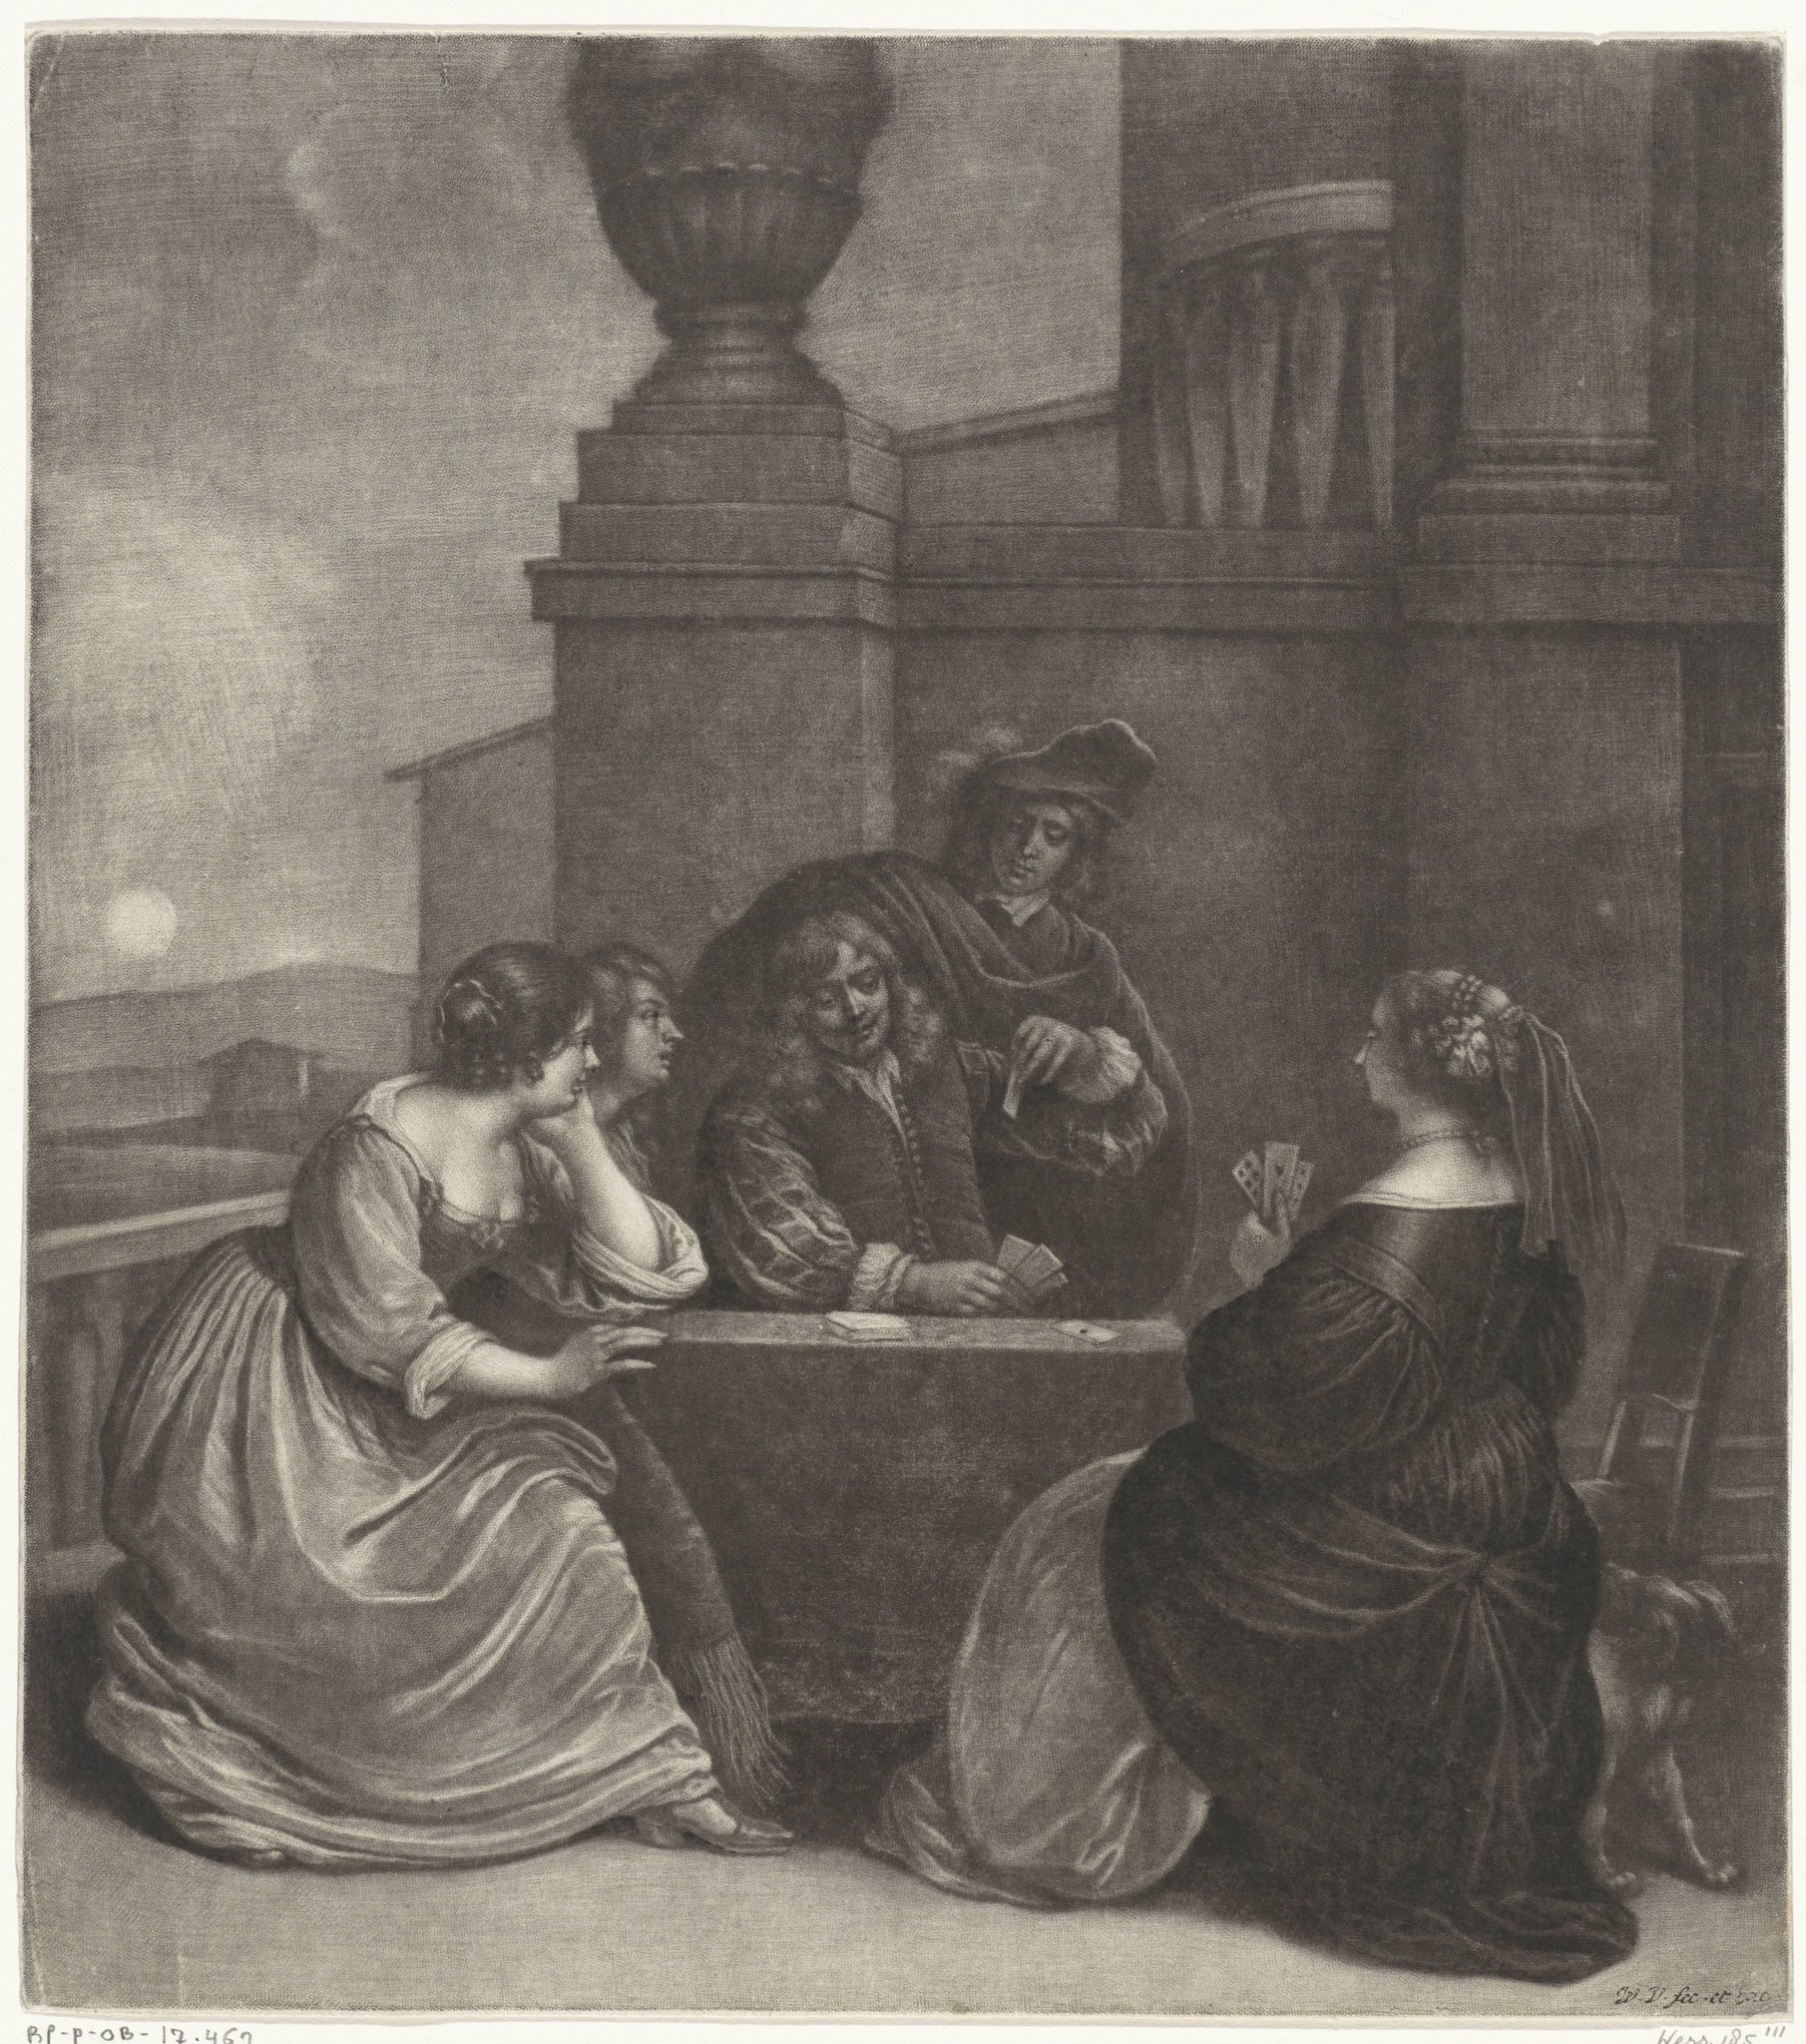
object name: print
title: Kaartspelend gezelschap op een terras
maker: wallerant vaillant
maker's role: draughtsman, painter, print maker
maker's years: 1623-1677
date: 1658-1677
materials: paper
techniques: mezzotint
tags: playing-cards, dog, private festivities, merry company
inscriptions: collector's mark: Lugt 2228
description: Op een terras zit een elegant gezelschap van mannen en vrouwen kaart te spelen.